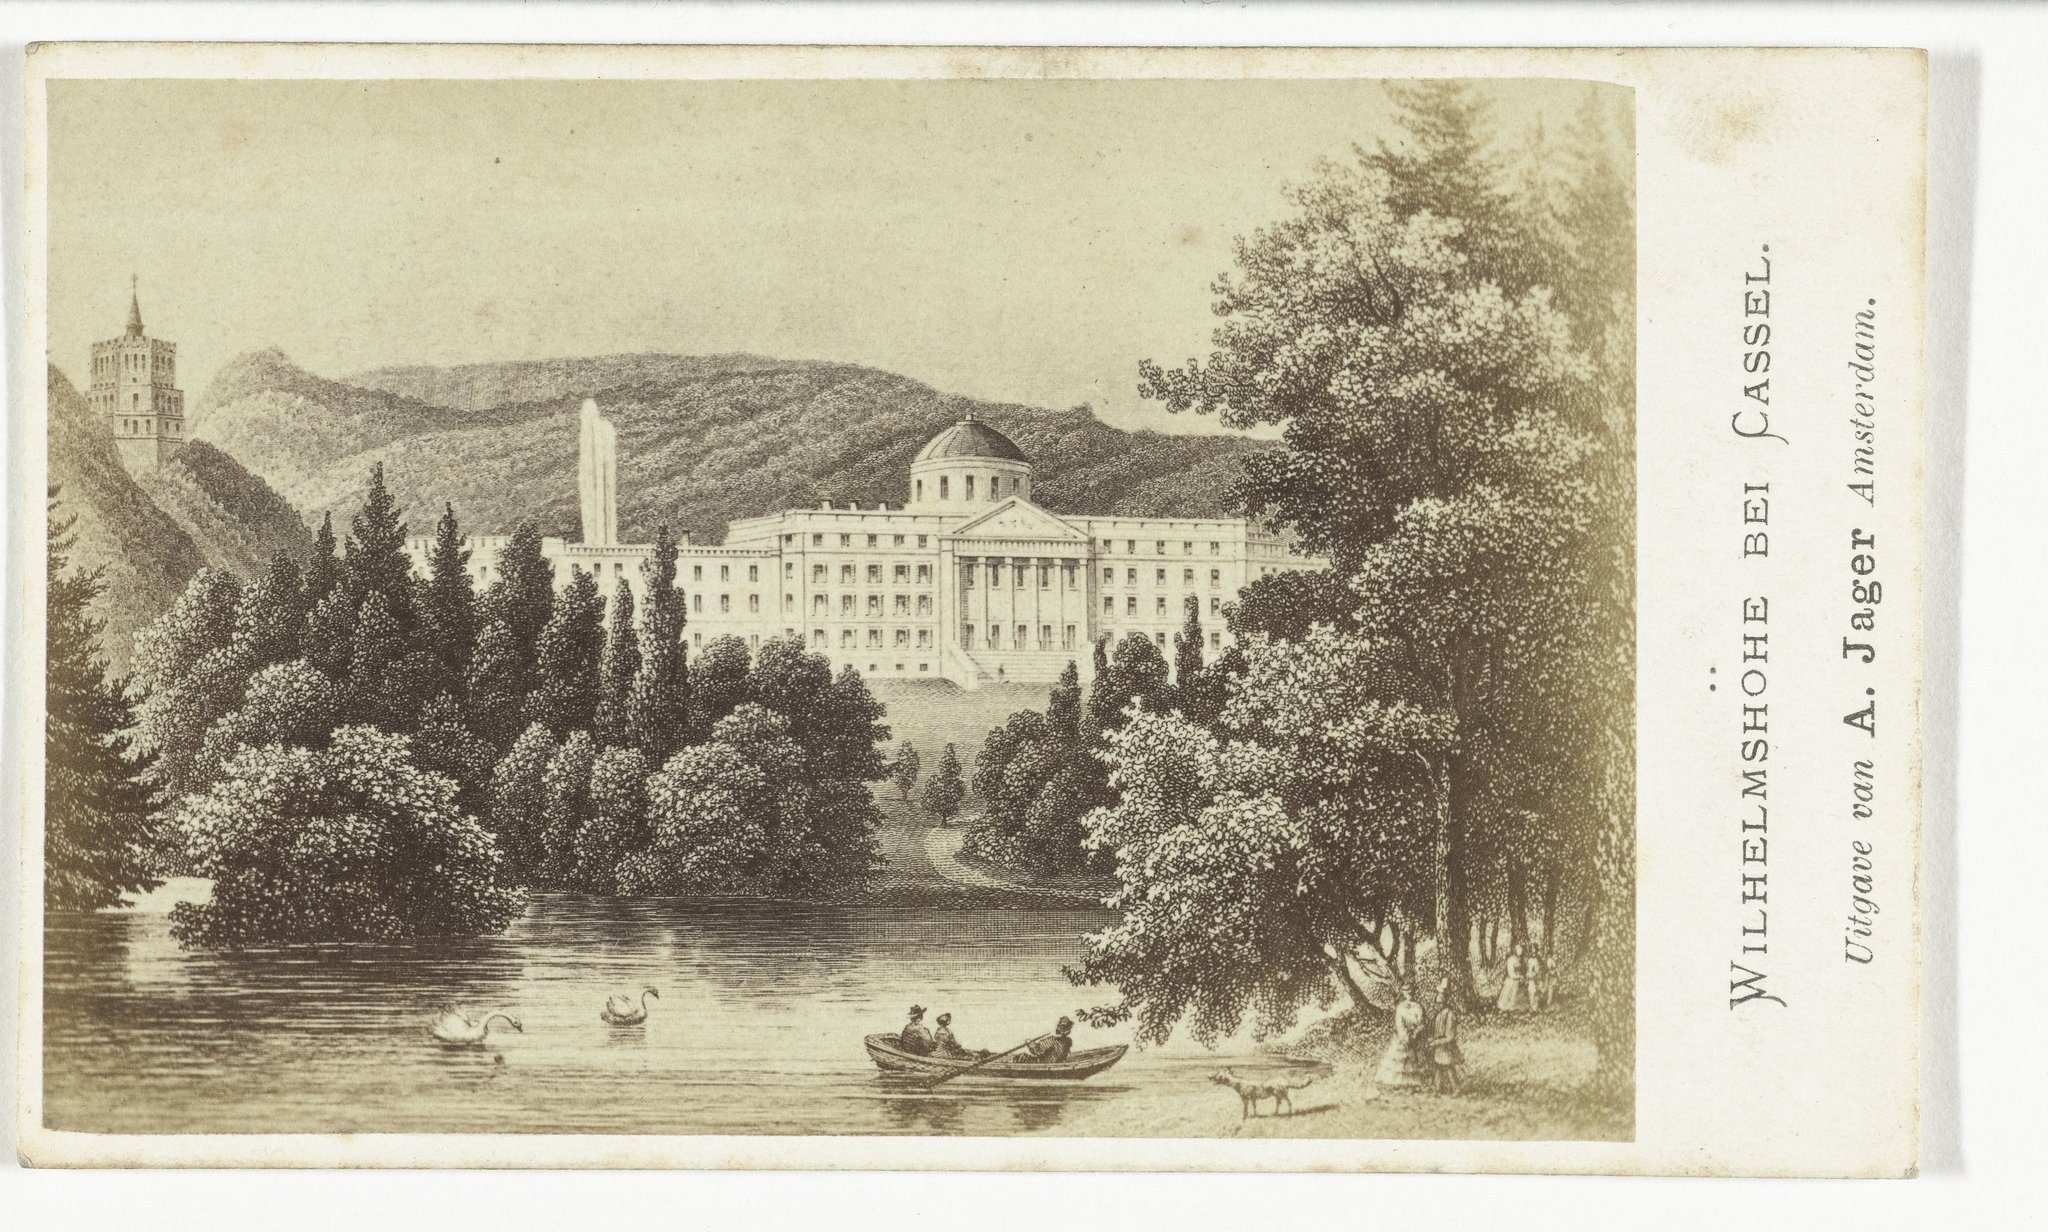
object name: photograph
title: Fotoreproductie van een gravure van een gezicht op Schloss Wilhelmshöhe in Kassel, Duitsland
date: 1860-1900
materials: cardboard, photographic support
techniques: albumen print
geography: amsterdam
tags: castle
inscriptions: number: ‘2.00’, number: ‘€ 1.-’